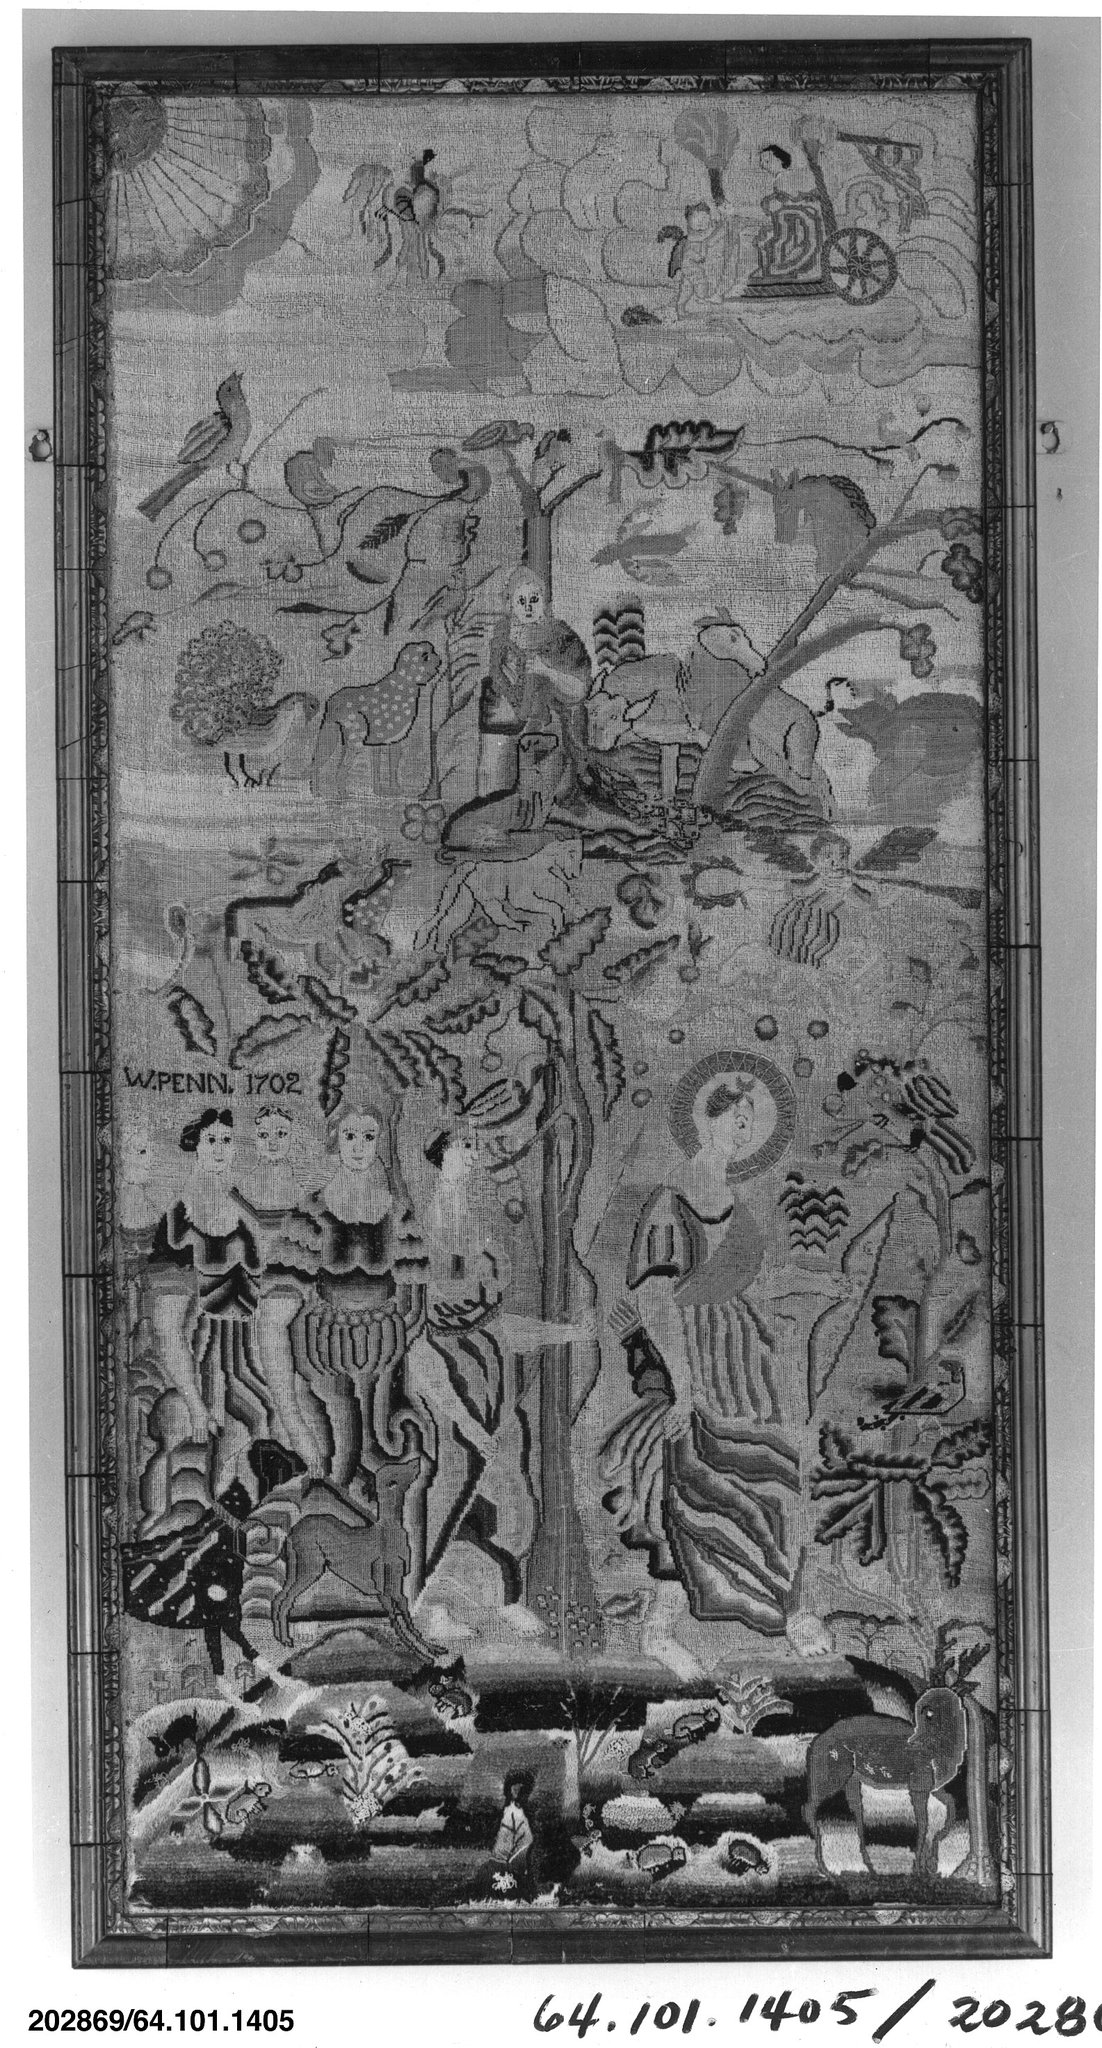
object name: embroidered picture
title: Embroidered picture with mythological scenes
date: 1702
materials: canvas, metal thread, silk, wool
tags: human figures,animals,birds,unicorns